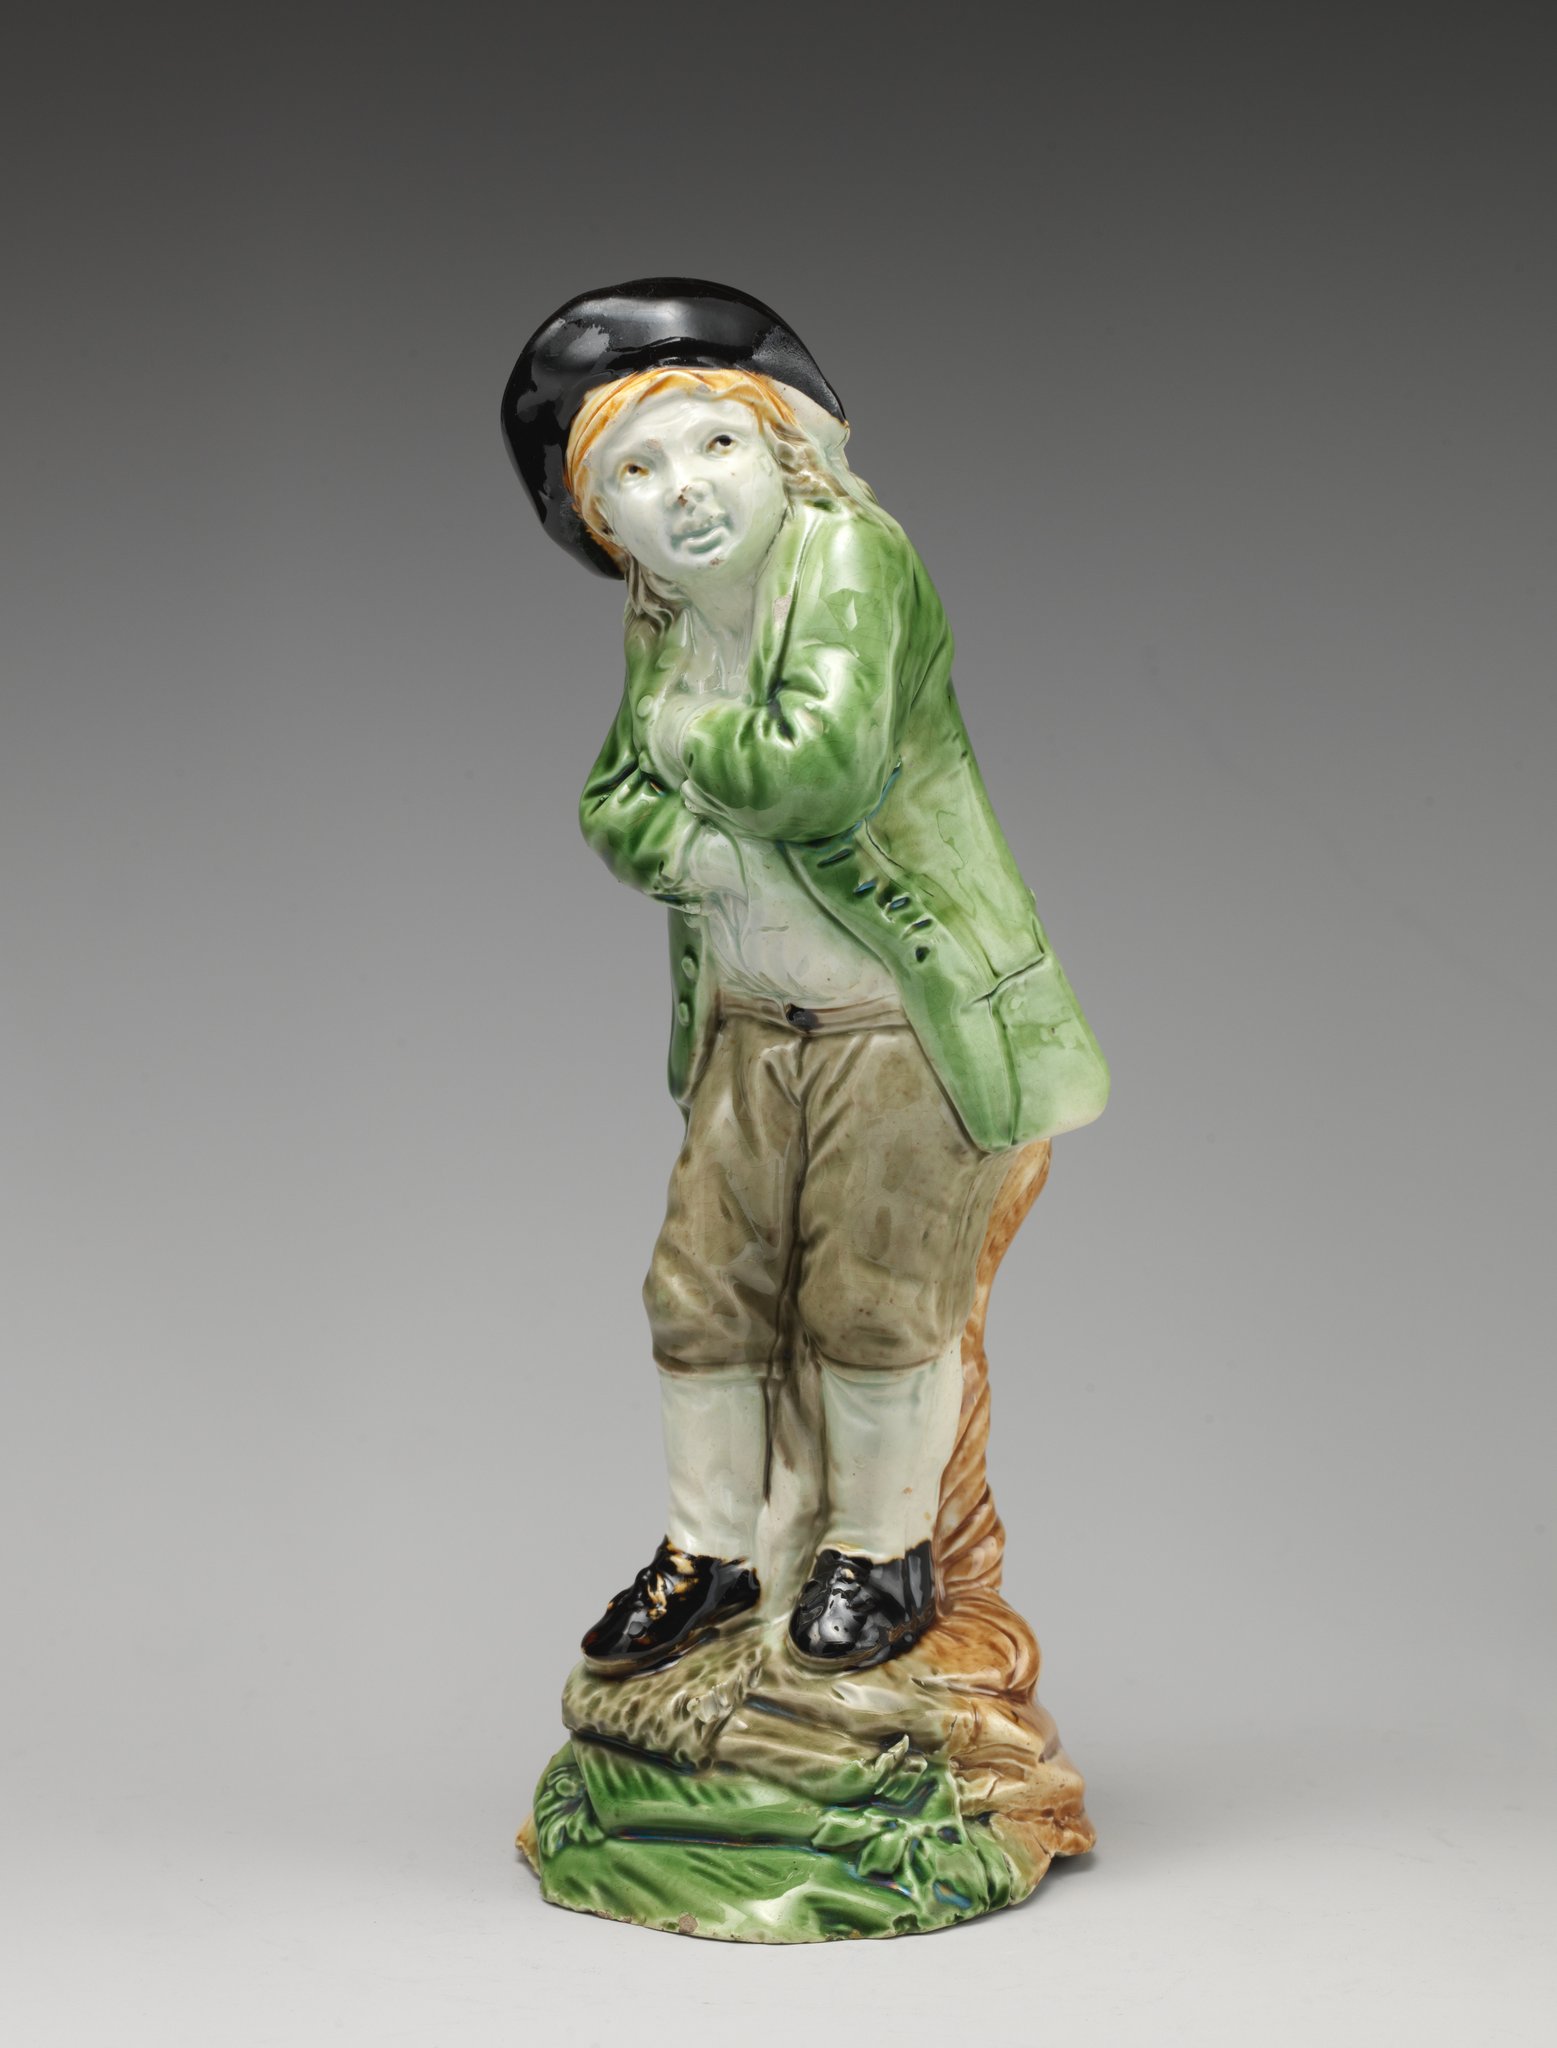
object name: figure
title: Sweep boy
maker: ralph wood the younger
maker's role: maker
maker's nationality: british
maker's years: 1748-1795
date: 1770-1780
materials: earthenware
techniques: glazing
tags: boys